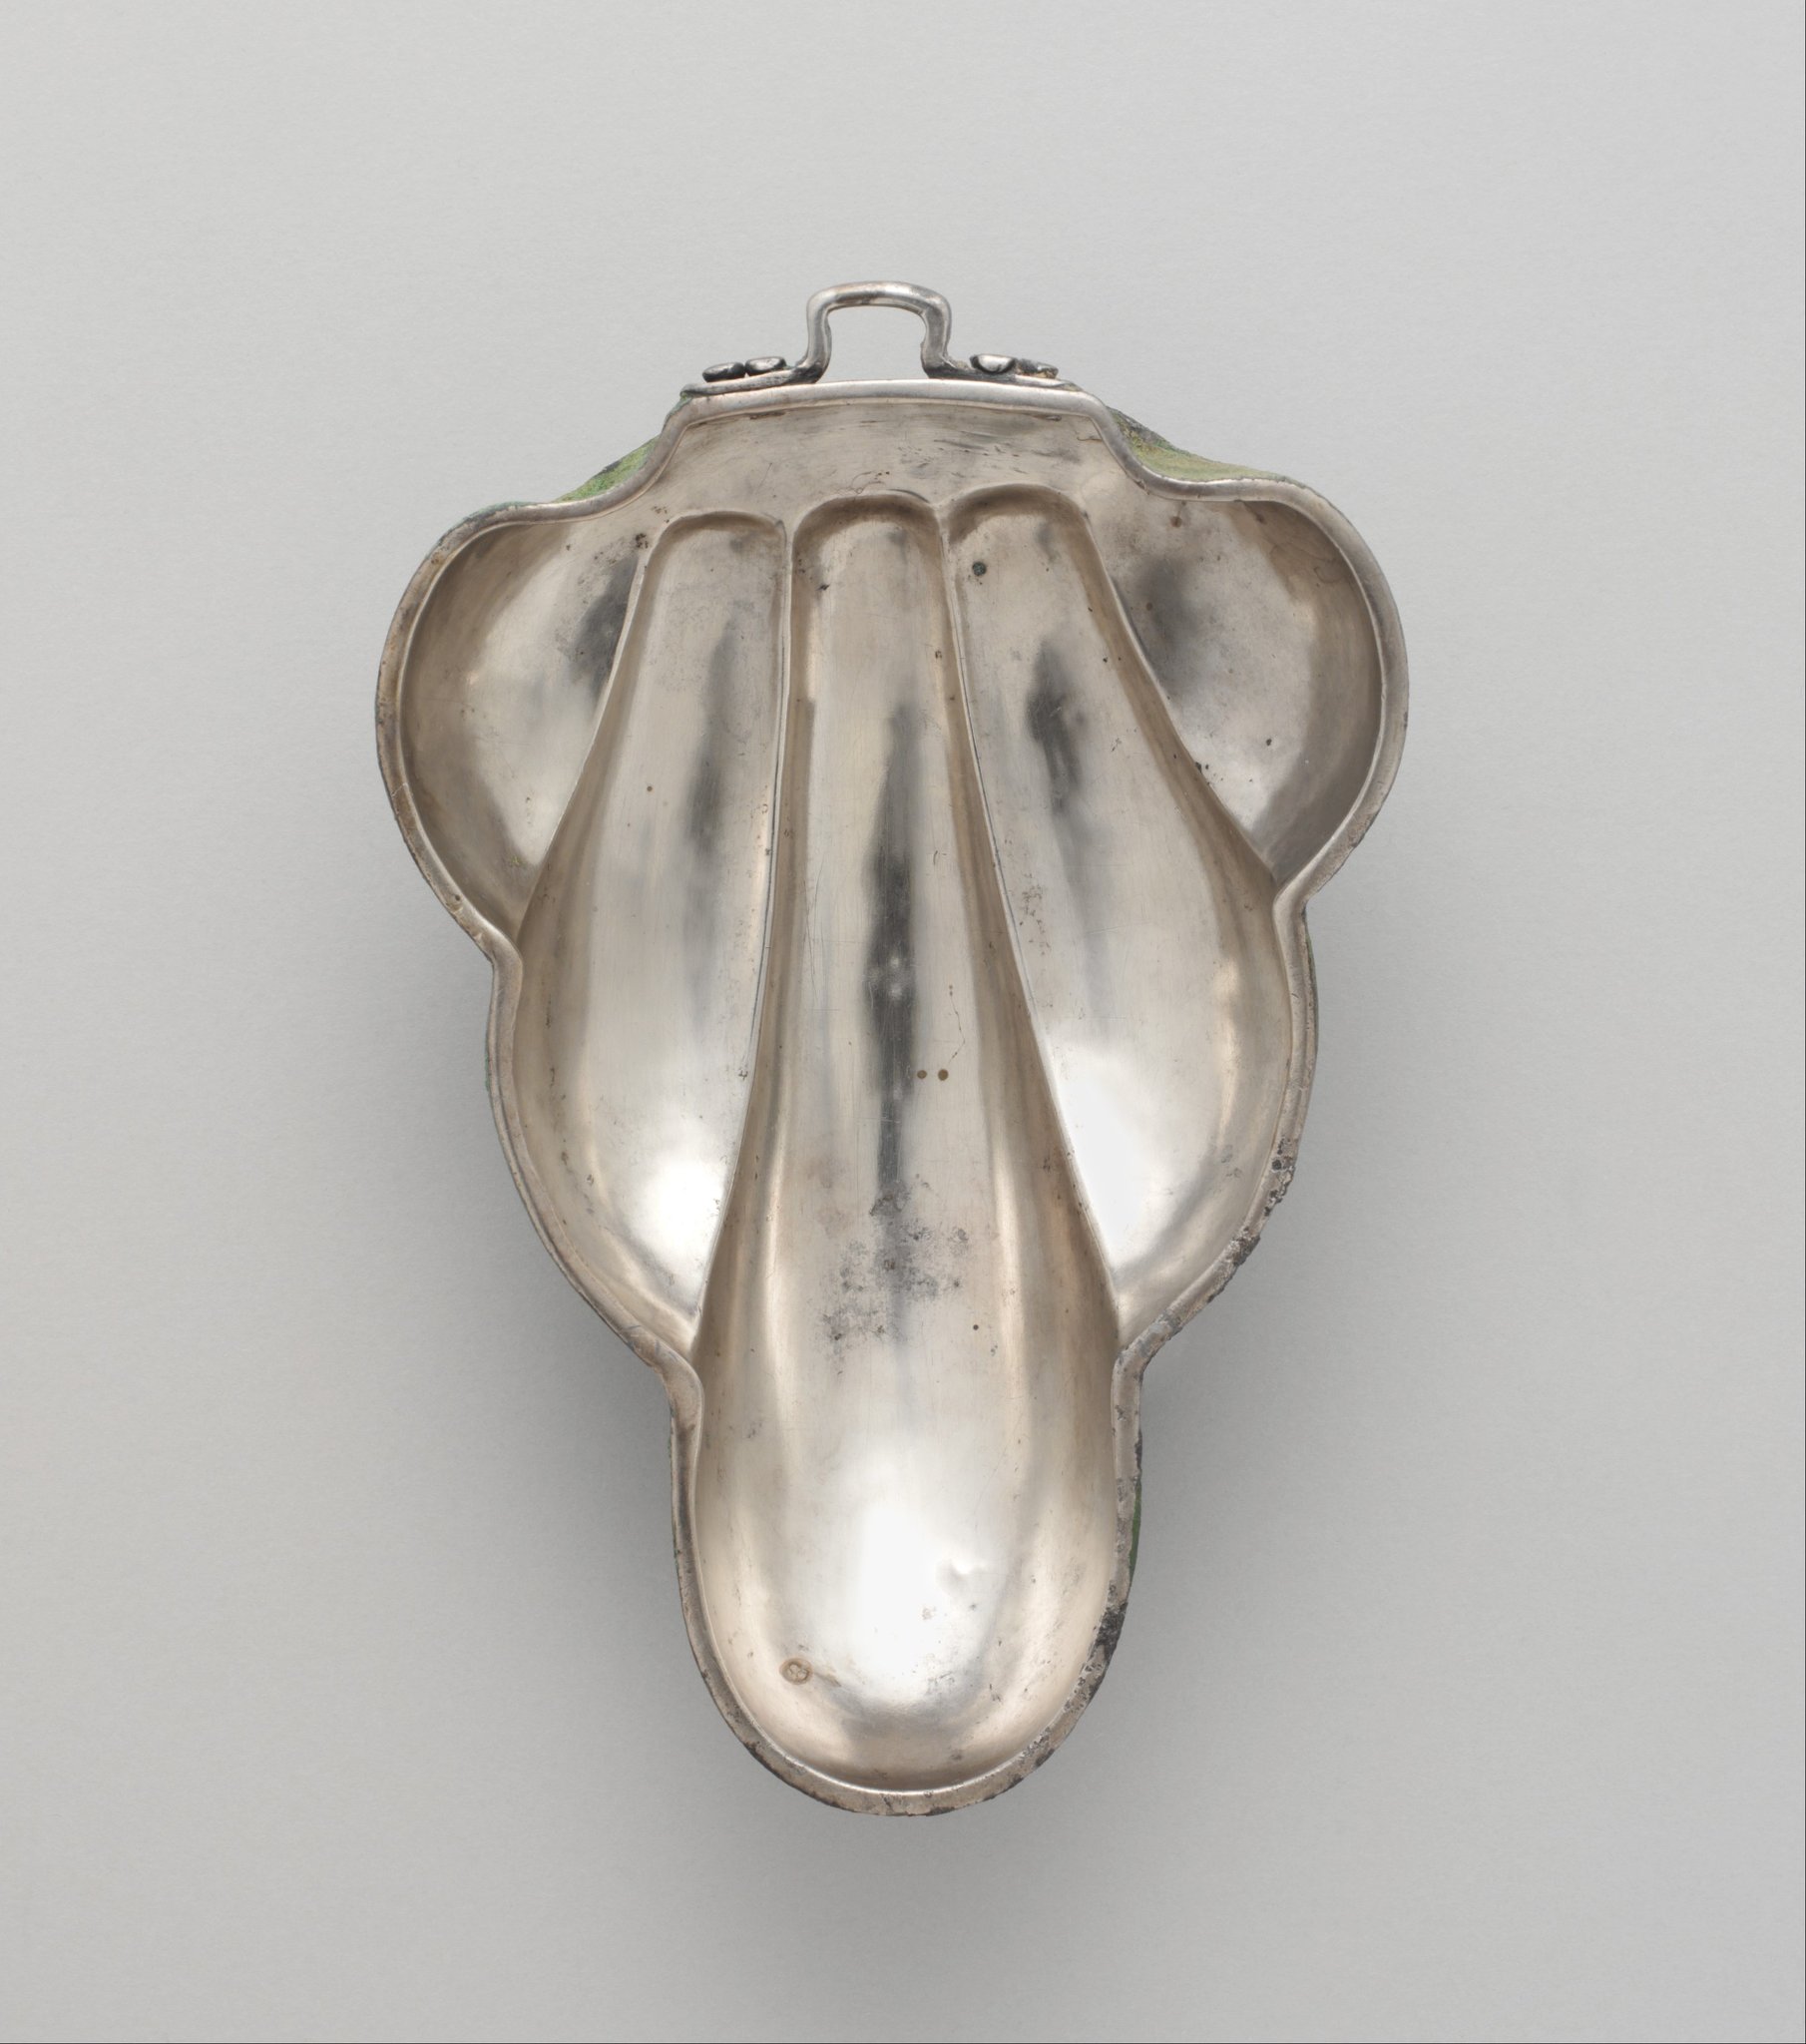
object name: bowl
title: Half-lobed bowl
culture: sasanian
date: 501-600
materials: silver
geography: iran